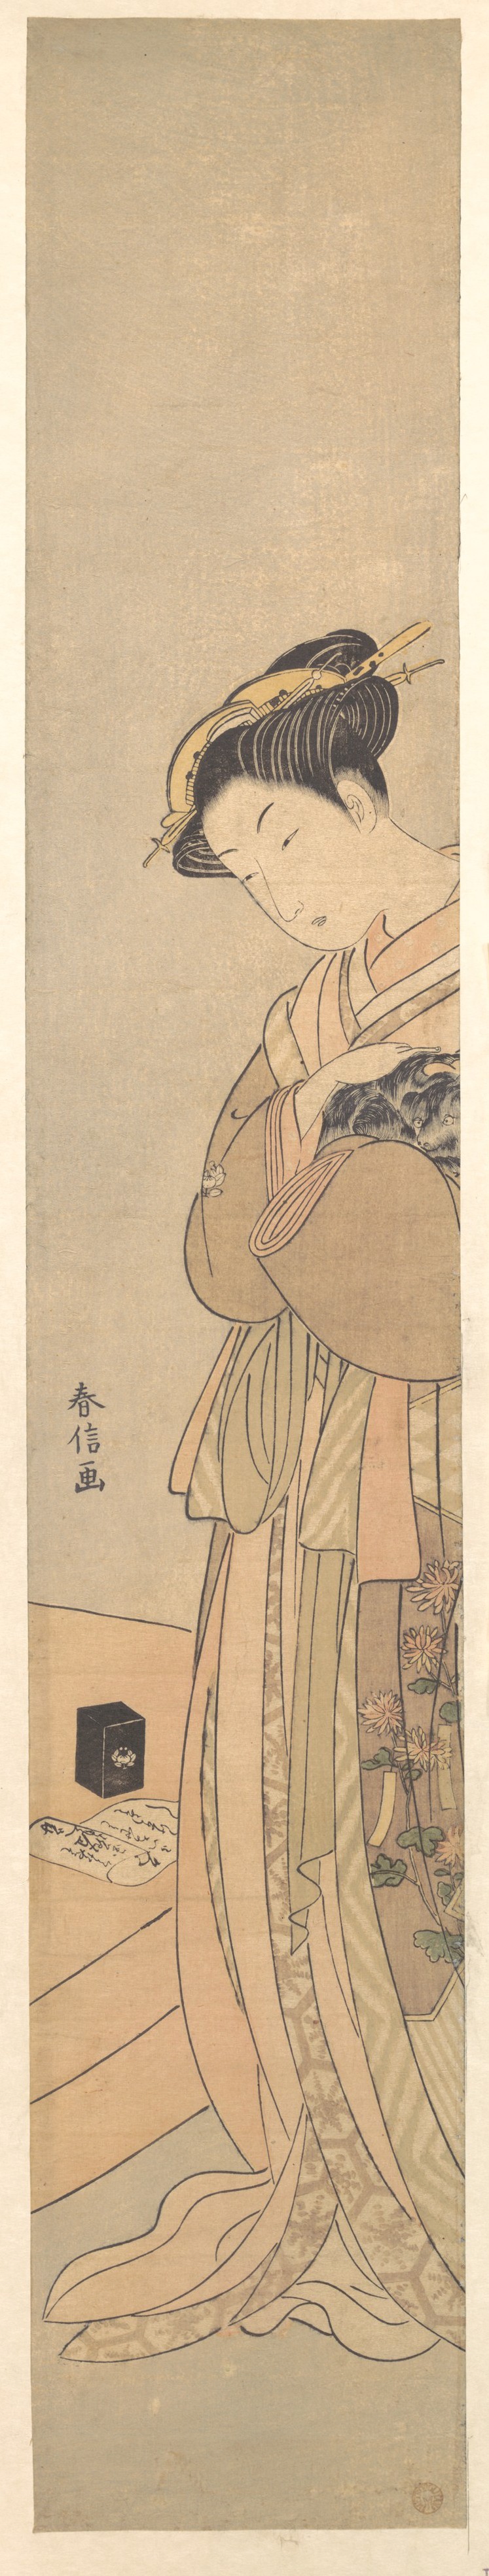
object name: print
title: An Oiran Holding a Black Dog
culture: japanese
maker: suzuki harunobu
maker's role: artist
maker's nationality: japanese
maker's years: 1725-1770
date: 1769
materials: ink, paper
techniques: woodblock print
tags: women